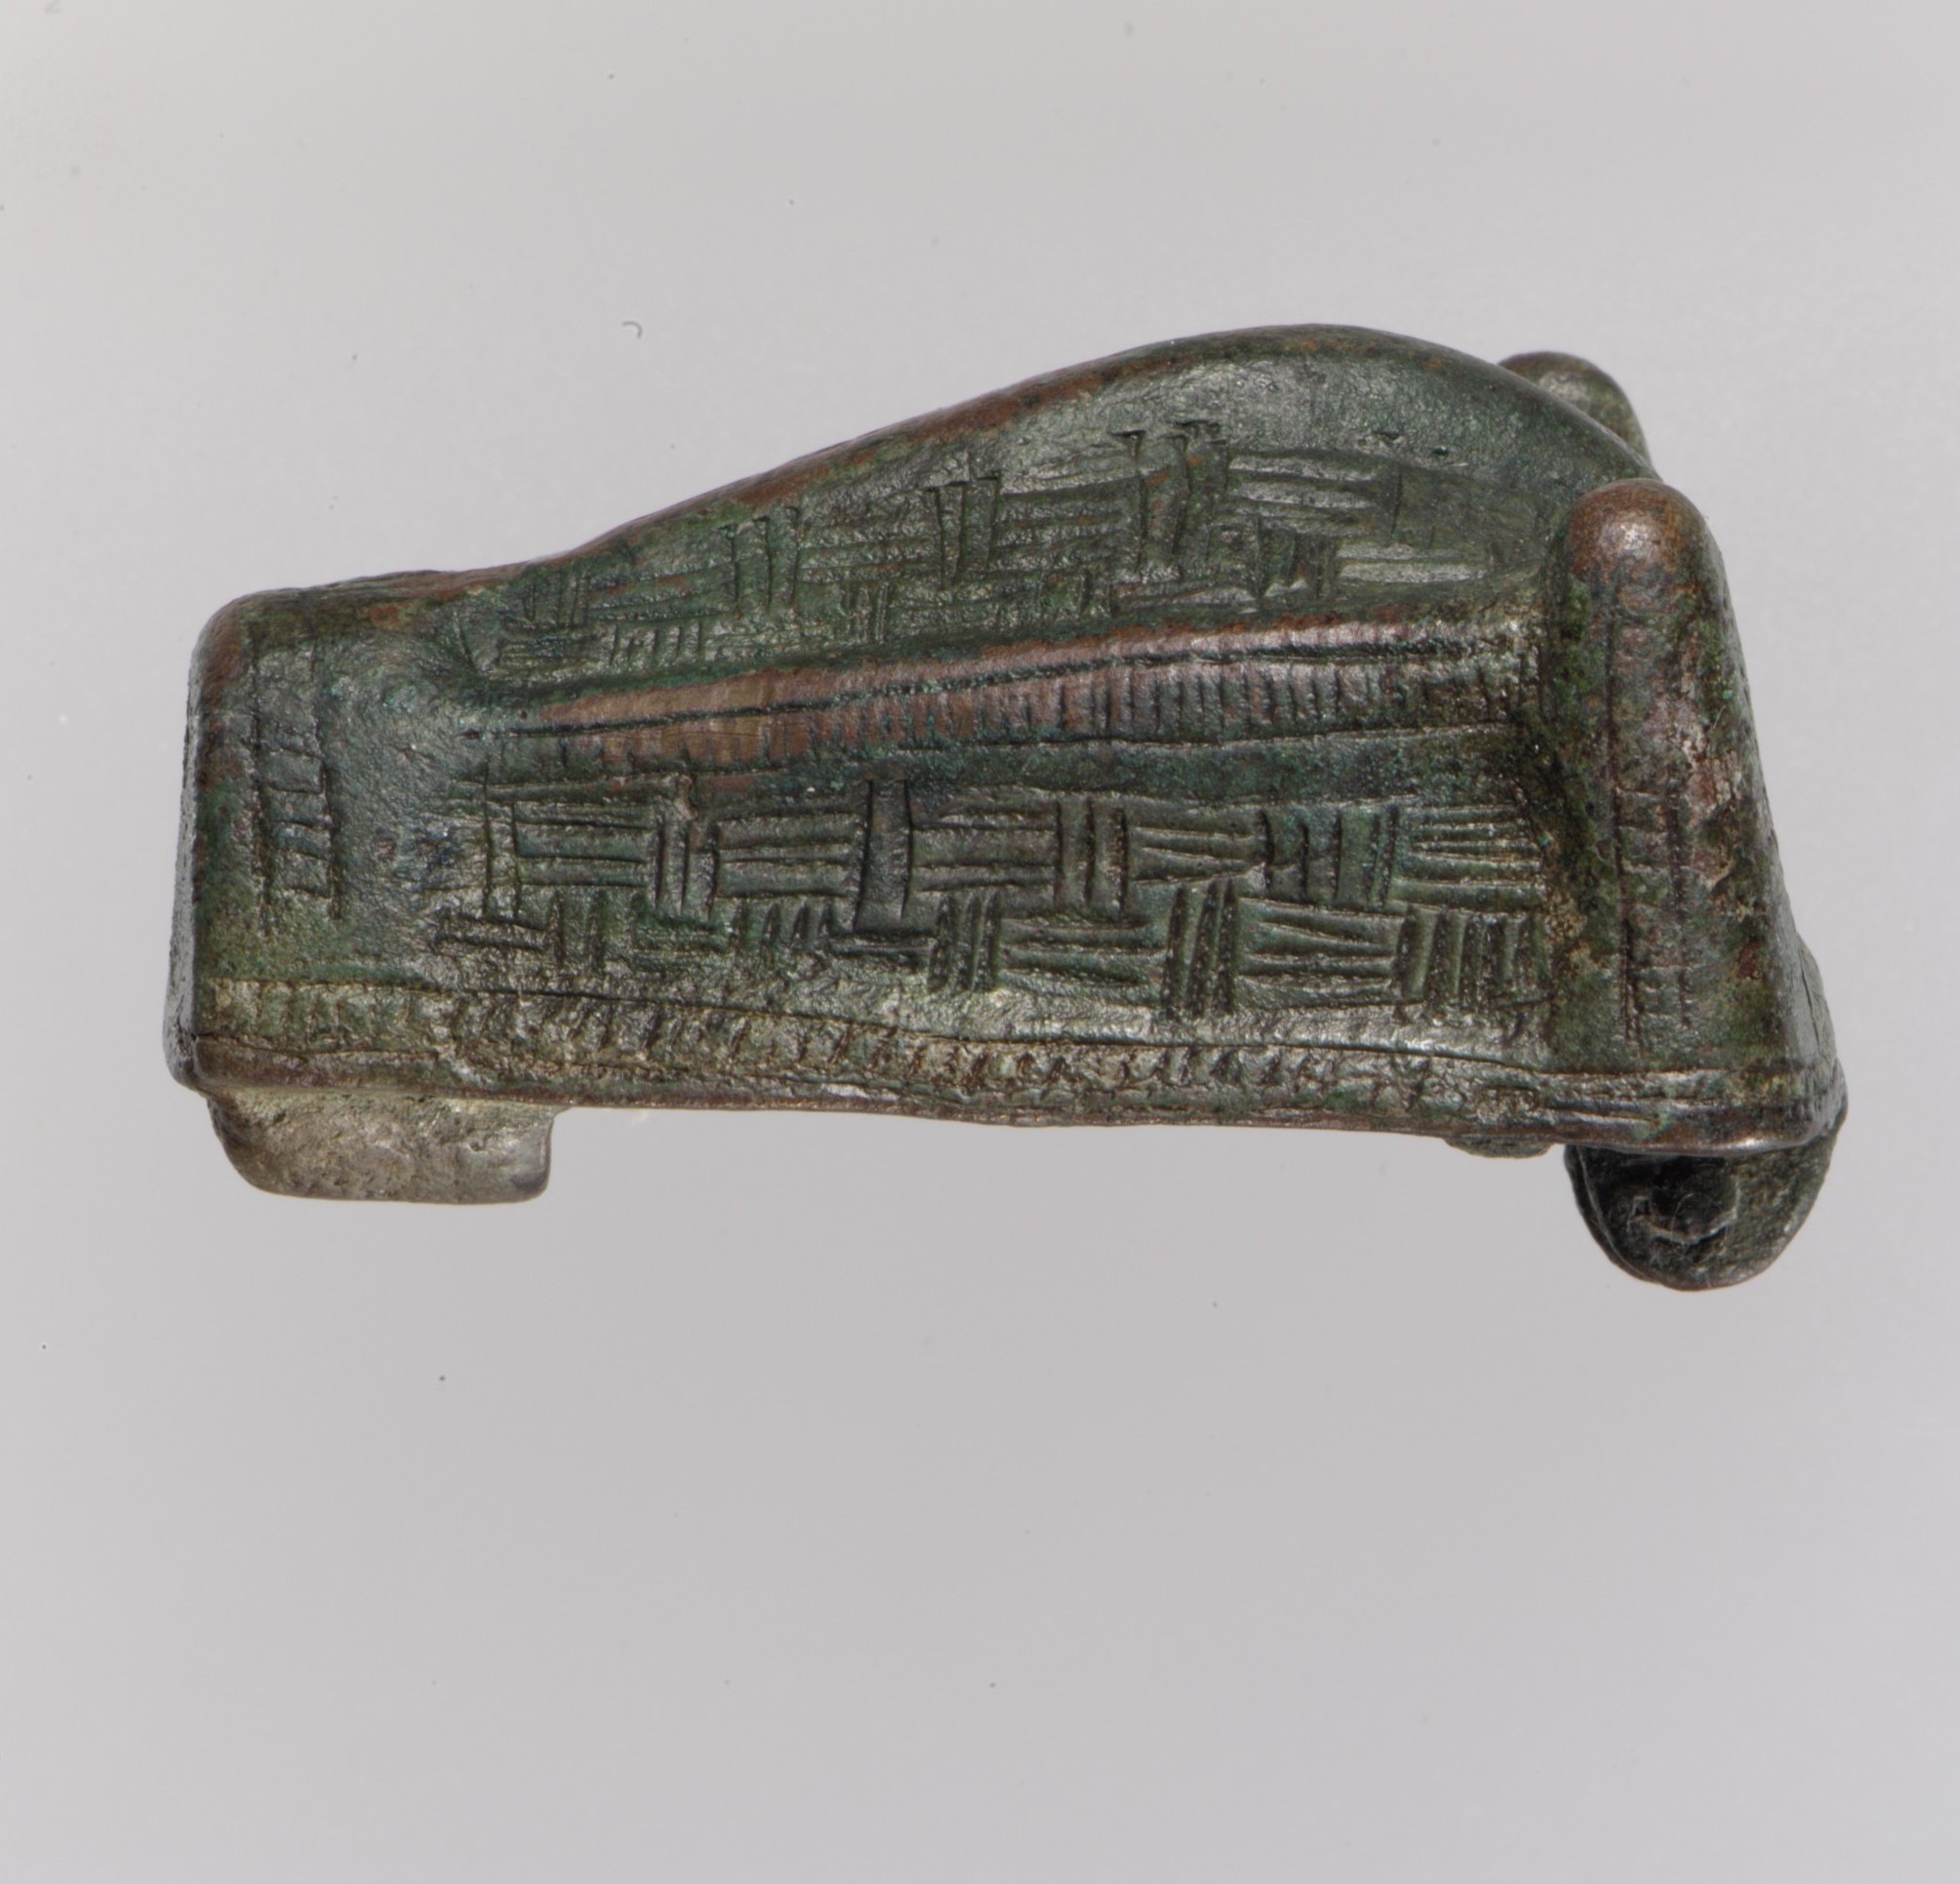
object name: brooch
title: Animal-Head Brooch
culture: viking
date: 1000-1100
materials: copper alloy, gilt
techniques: casting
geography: sweden